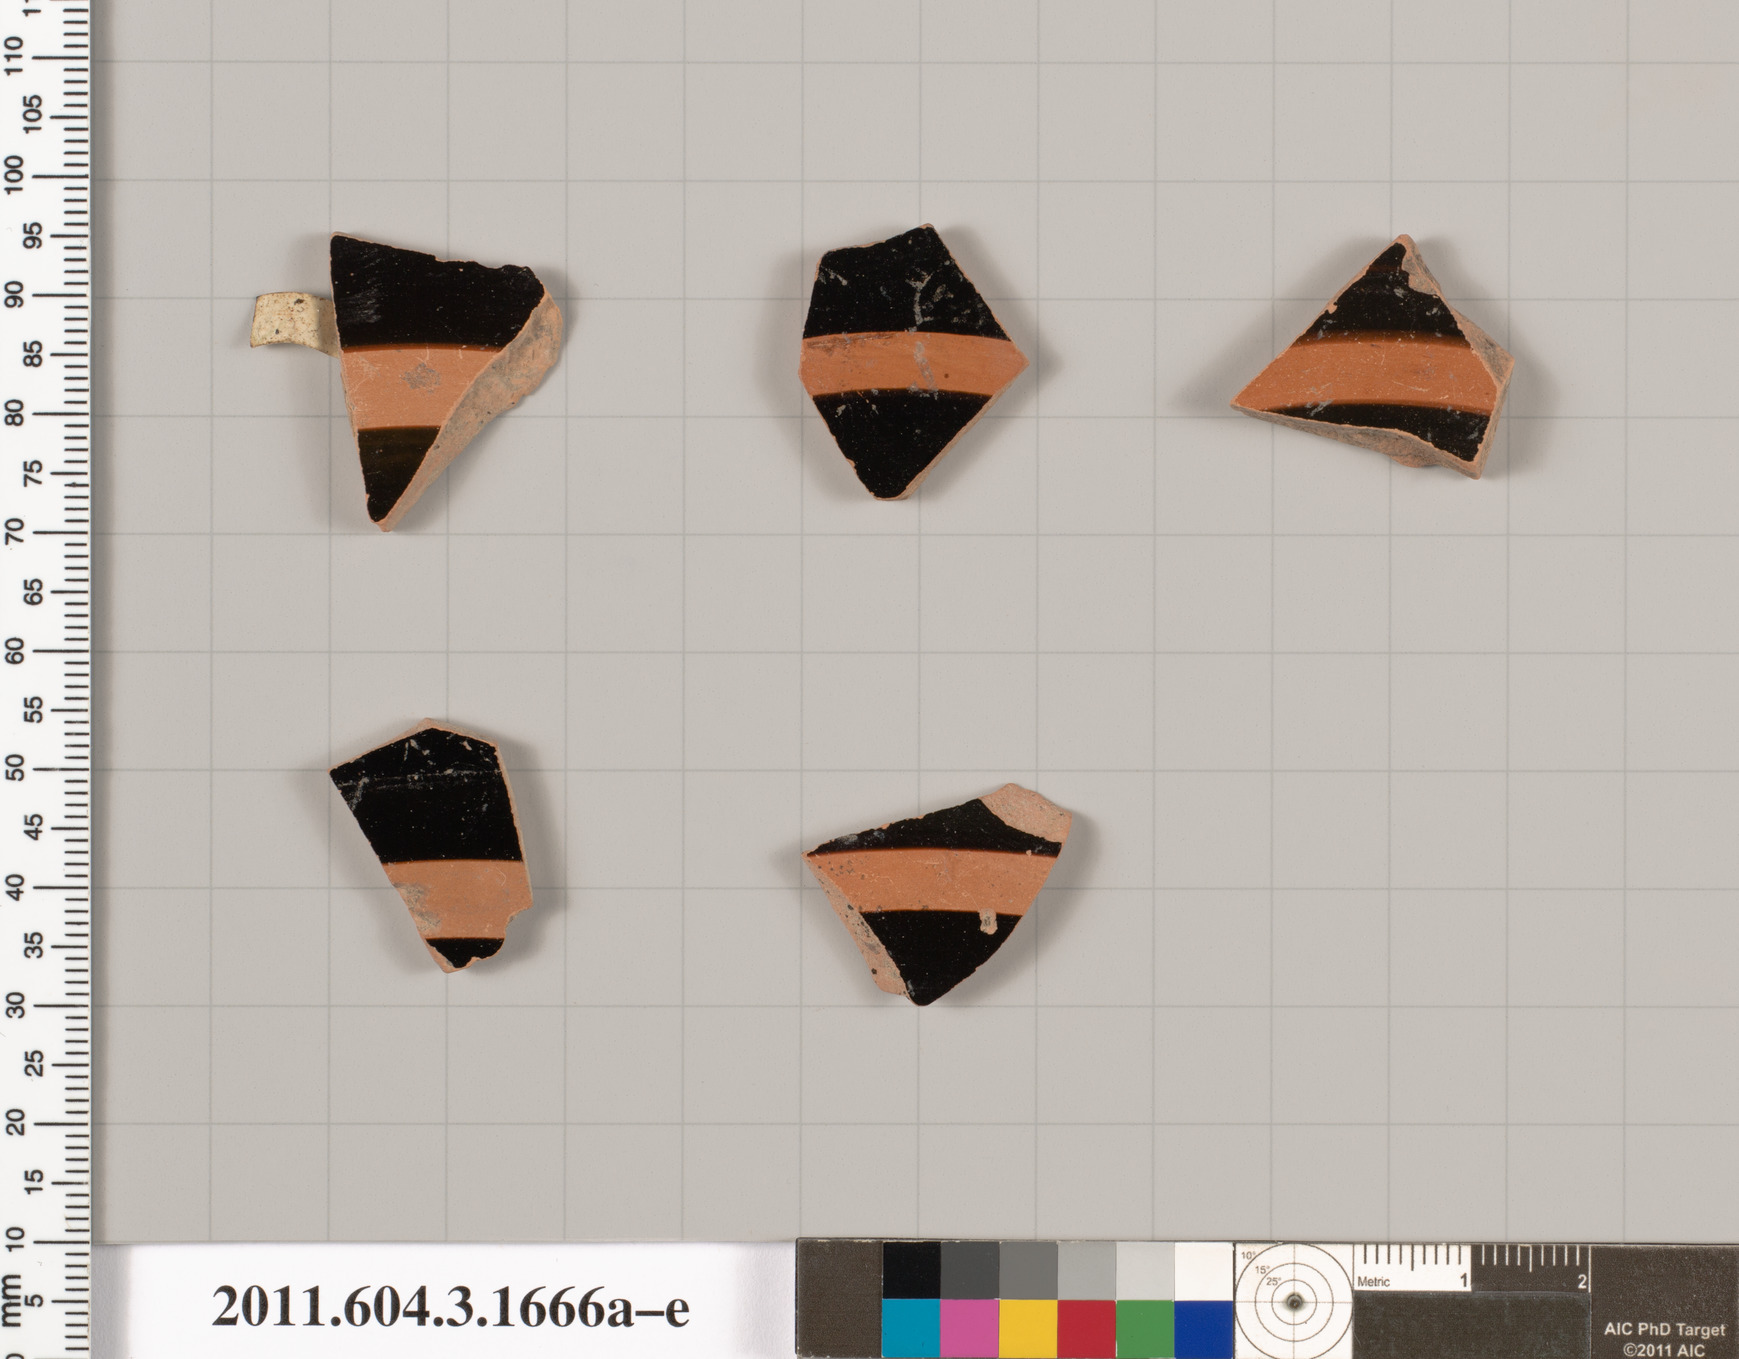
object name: kylix fragment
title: Terracotta fragments of kylikes: Band or lip cups (drinking cups)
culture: greek, attic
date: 550-526 BCE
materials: terracotta